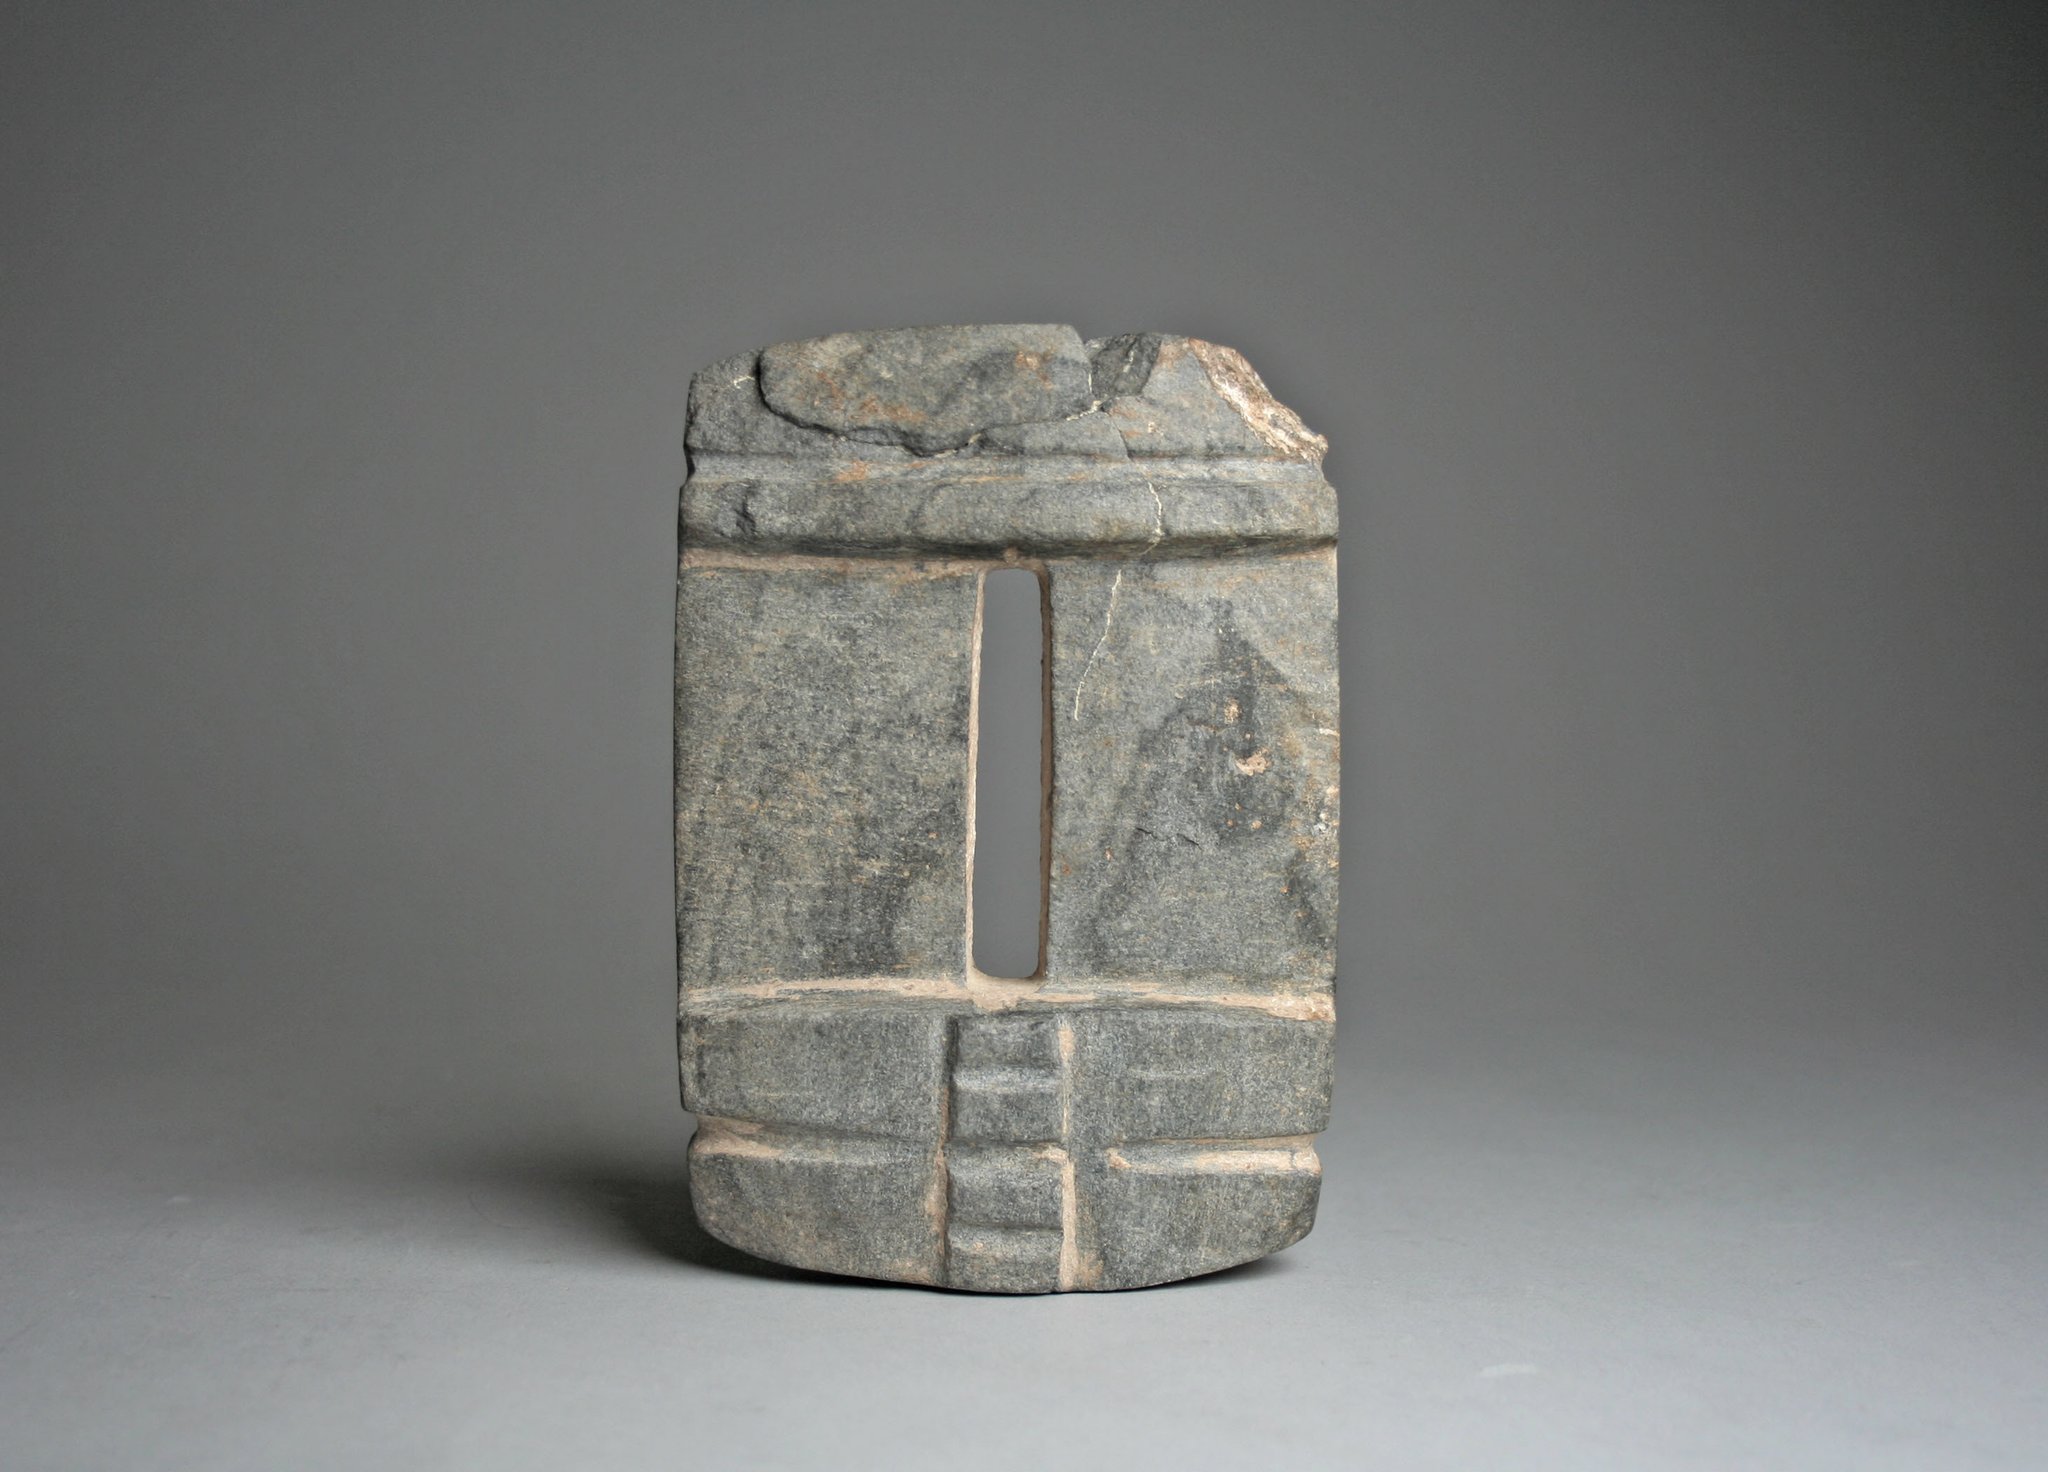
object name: architectural model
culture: mezcala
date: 1-800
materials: stone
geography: mexico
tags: temples